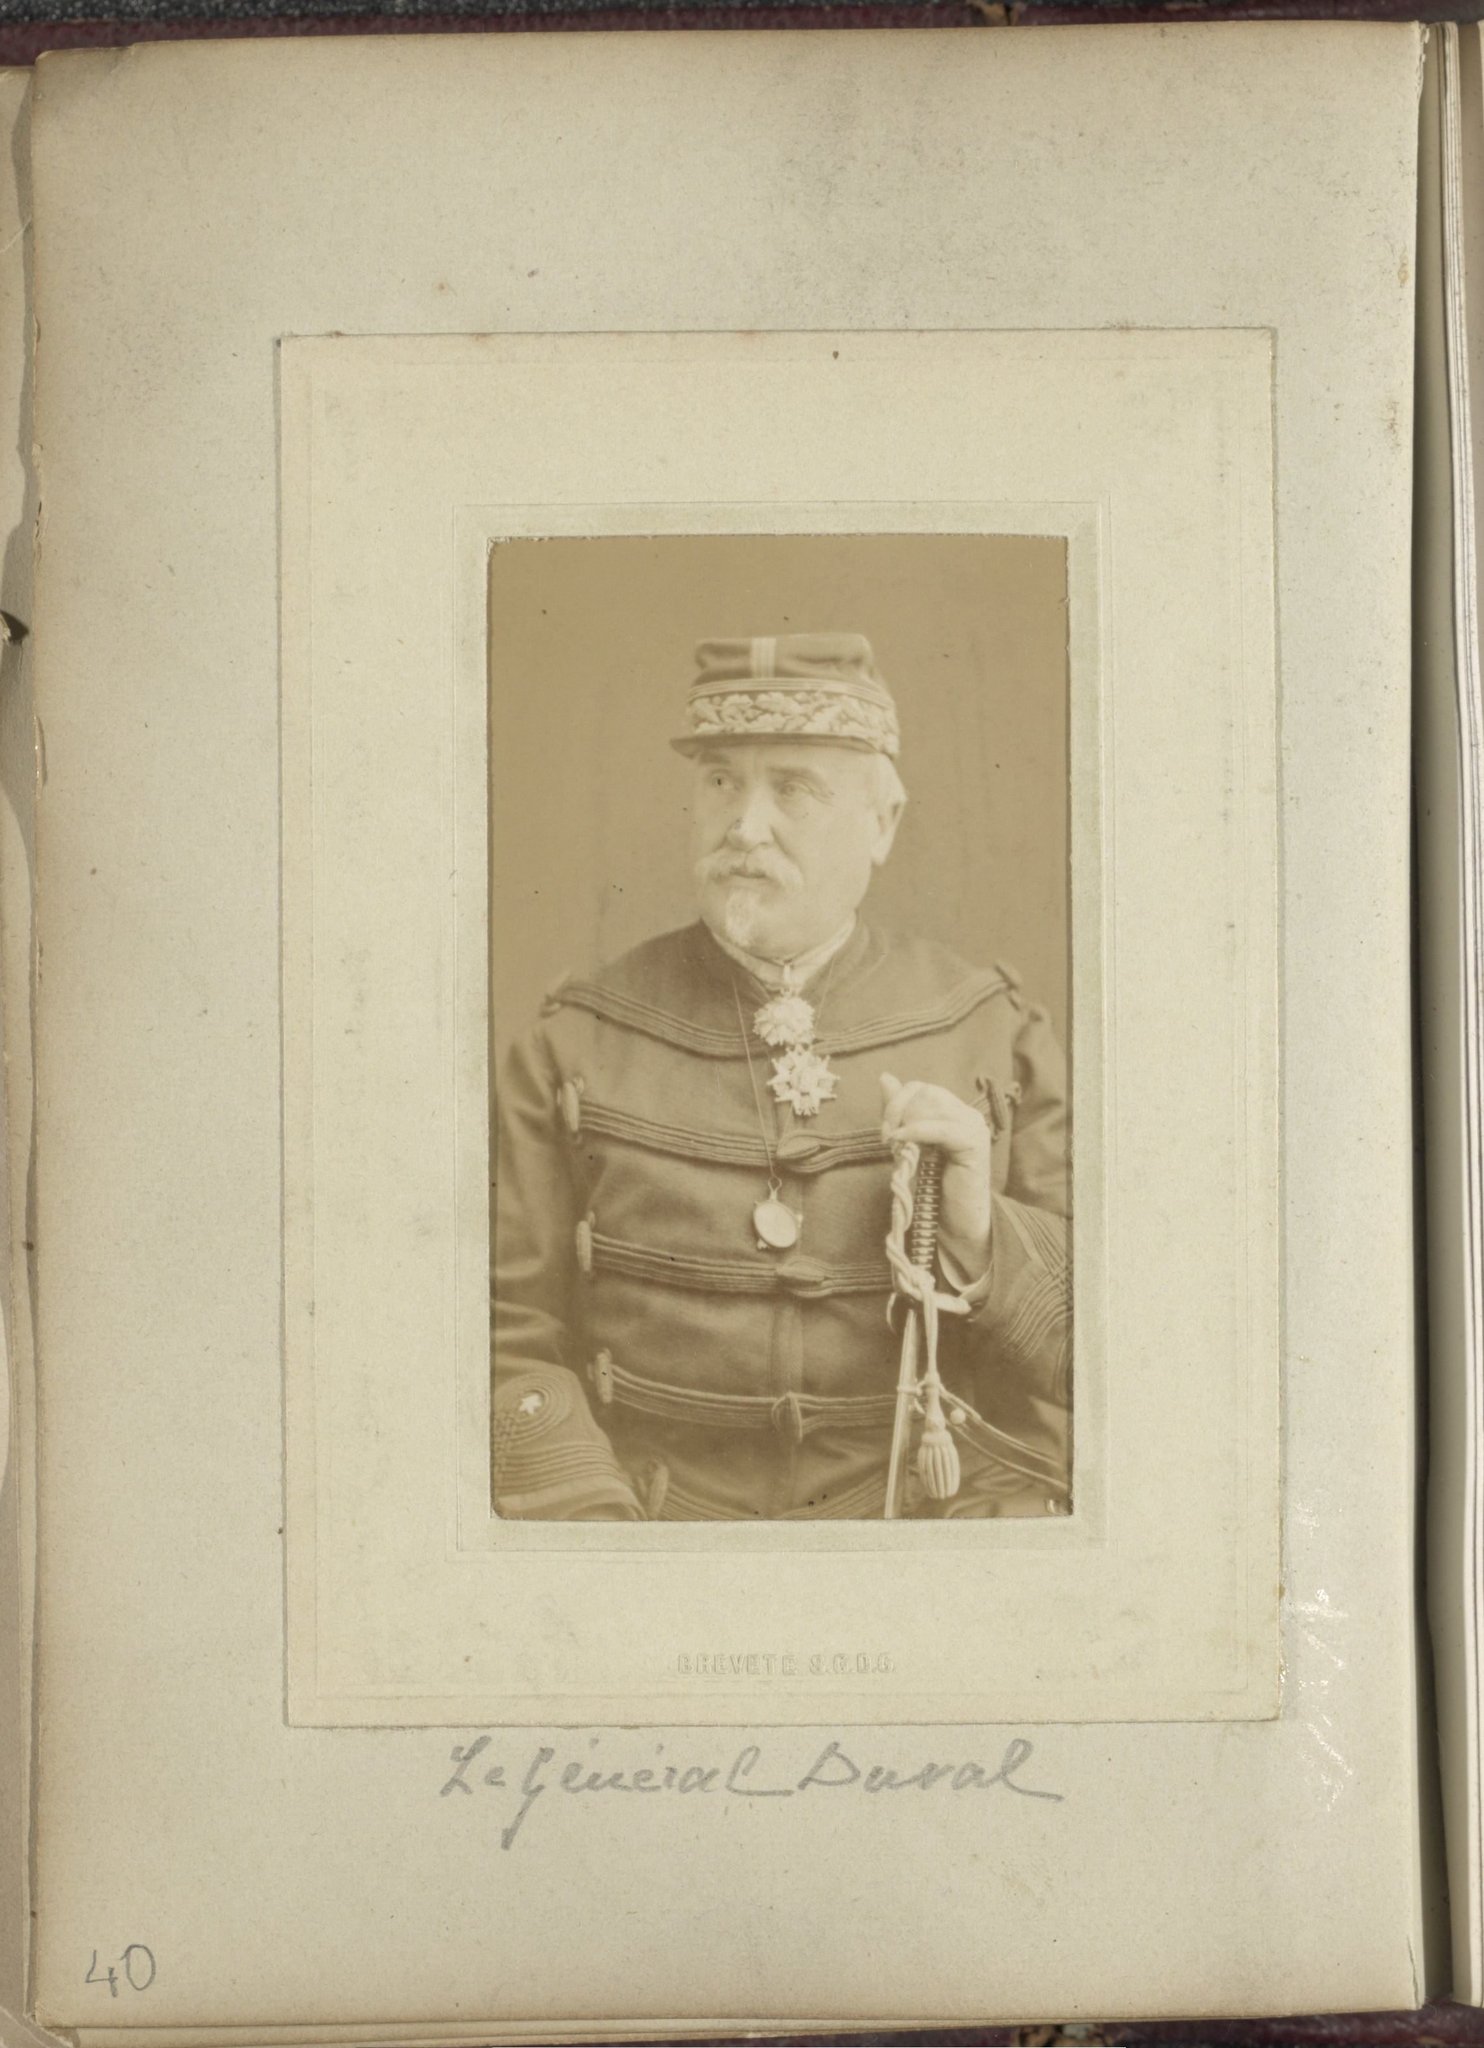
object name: photograph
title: Portret van generaal Duval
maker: antoine lumière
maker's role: painter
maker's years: 1840-1911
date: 1874-1893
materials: cardboard, paper, photographic support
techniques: albumen print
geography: lyon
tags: studio requisites ~ photographer, hacking and thrusting weapons (with name), moustache, historical persons, head-gear: cap, medals and other marks of military honour, (military) uniforms, watch, lyon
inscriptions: inscription: ‘le bon géneral Duval’, name: ‘Le Général [...] Duval’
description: Onderdeel van Fotoalbum met 48 cartes-de-visite aangeboden aan maarschalk graaf De Castellane.